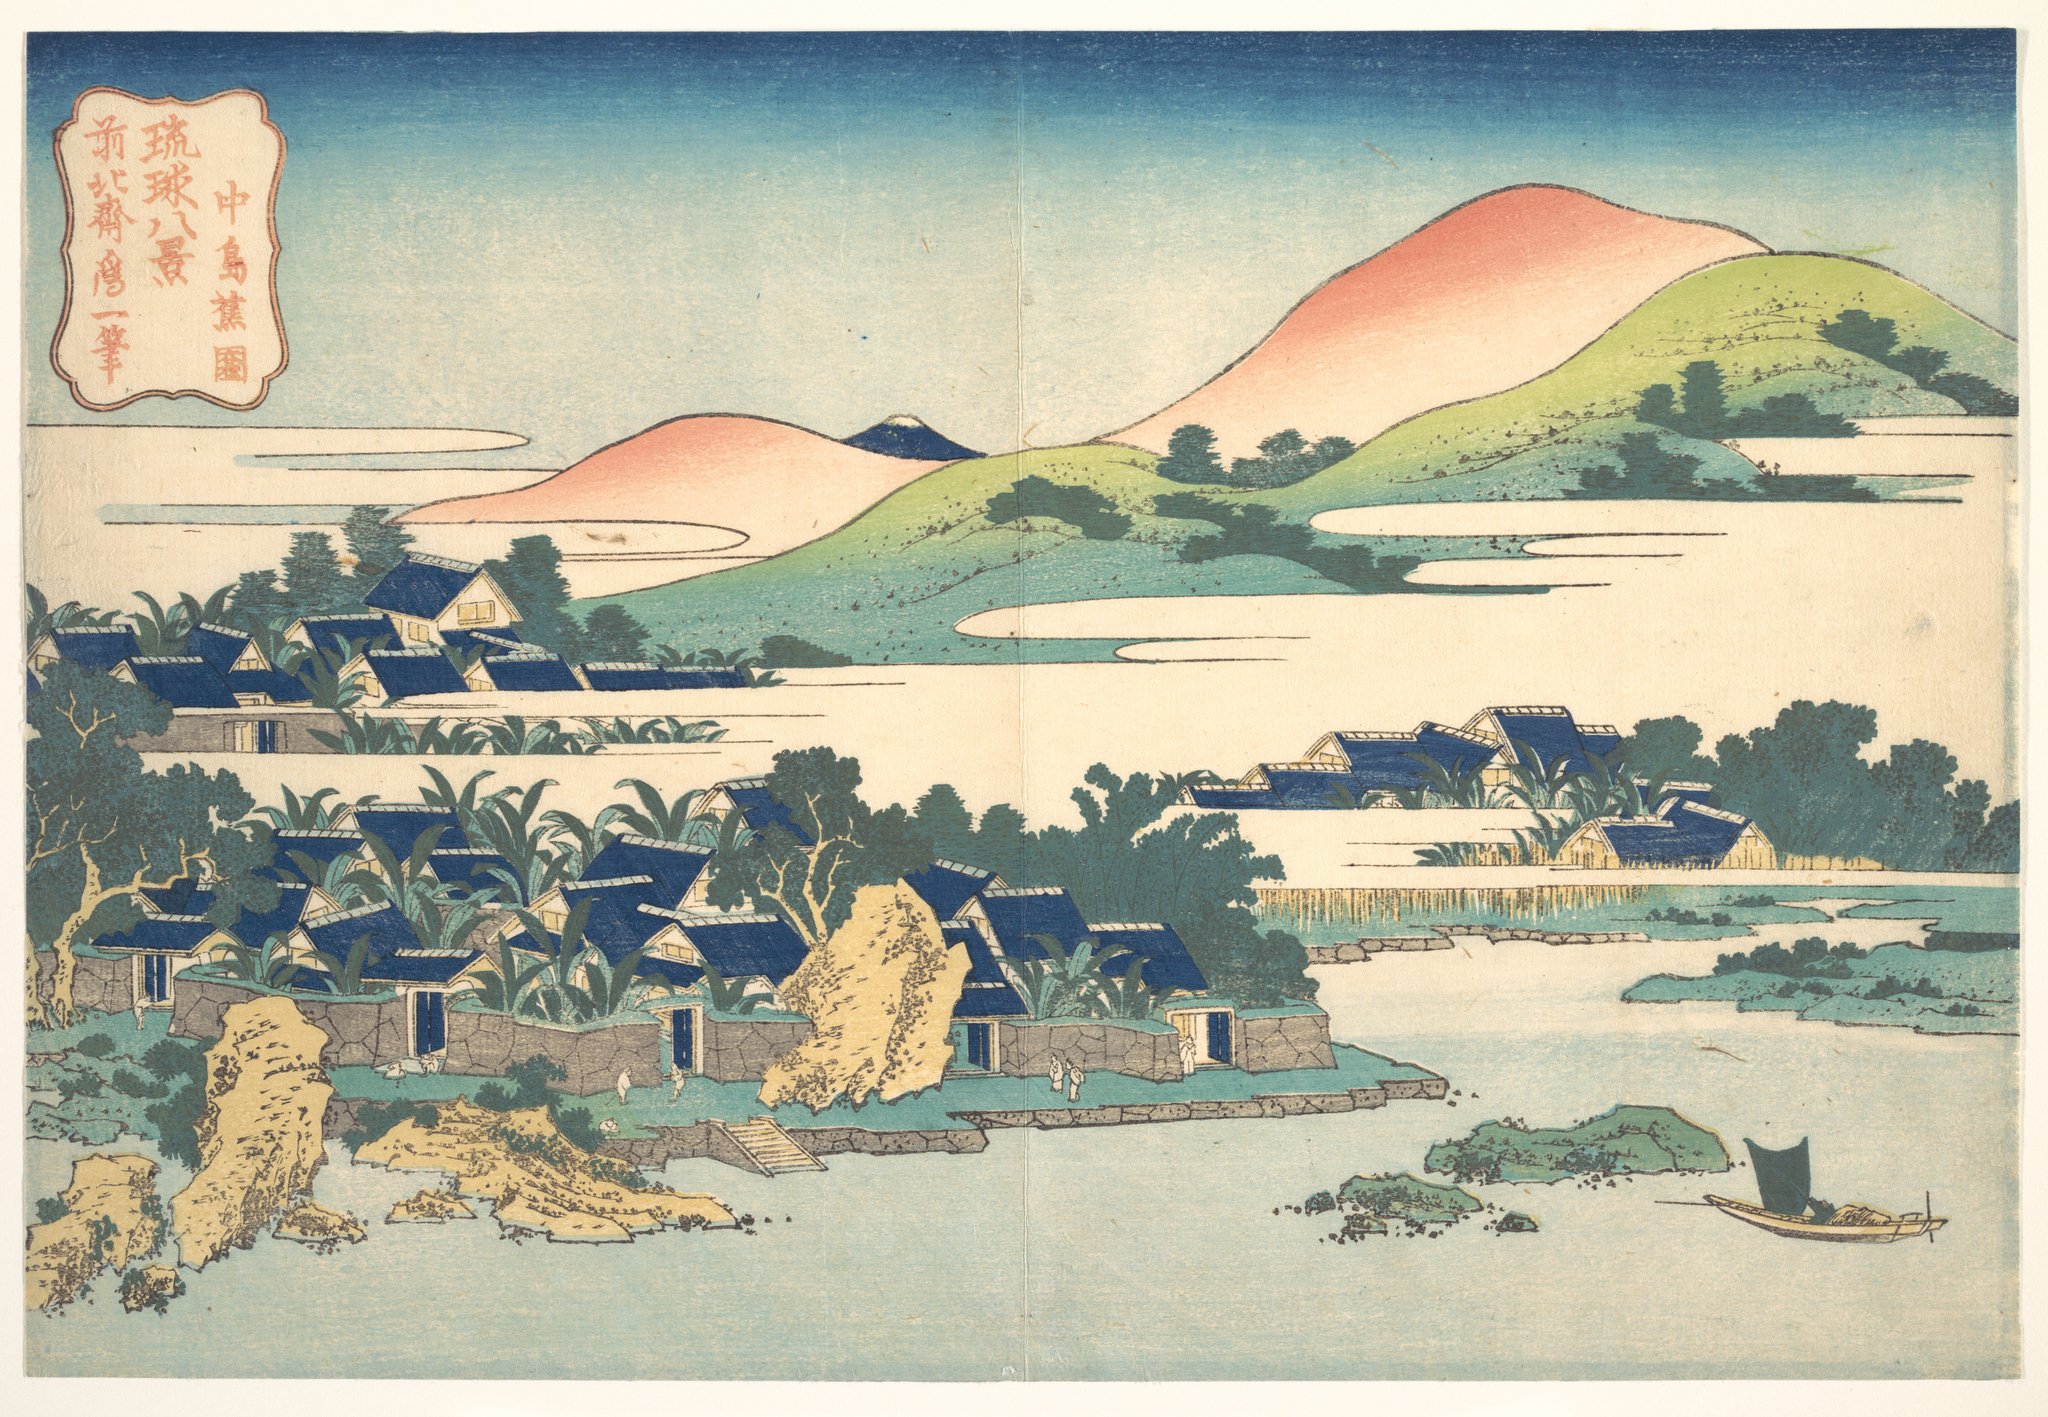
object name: woodblock print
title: Banana Garden at Nakashima (Nakashima shōen), from the series Eight Views of the Ryūkyū Islands (Ryūkyū hakkei)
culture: japanese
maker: katsushika hokusai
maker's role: artist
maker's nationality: japanese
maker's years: 1760-1849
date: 1832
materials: ink, paper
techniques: woodblock print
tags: houses,mountains,landscapes